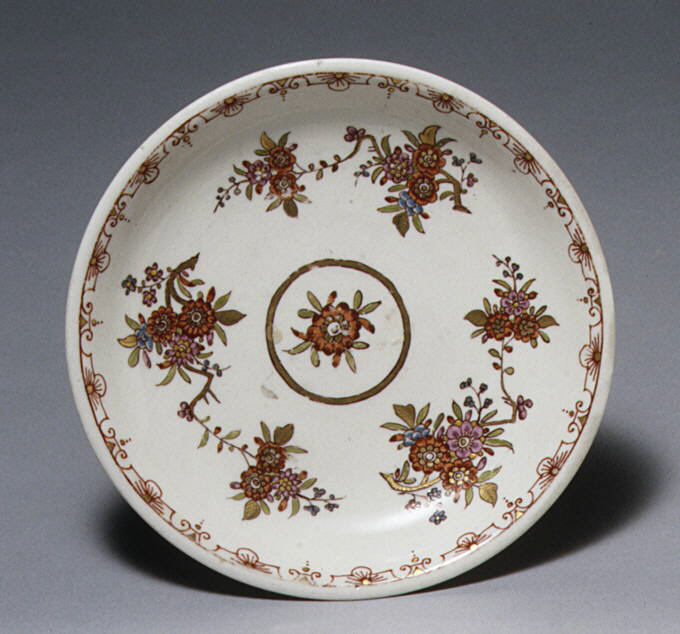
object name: saucer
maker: vienna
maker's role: manufactory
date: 1725-1735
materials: hard paste porcelain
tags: flowers